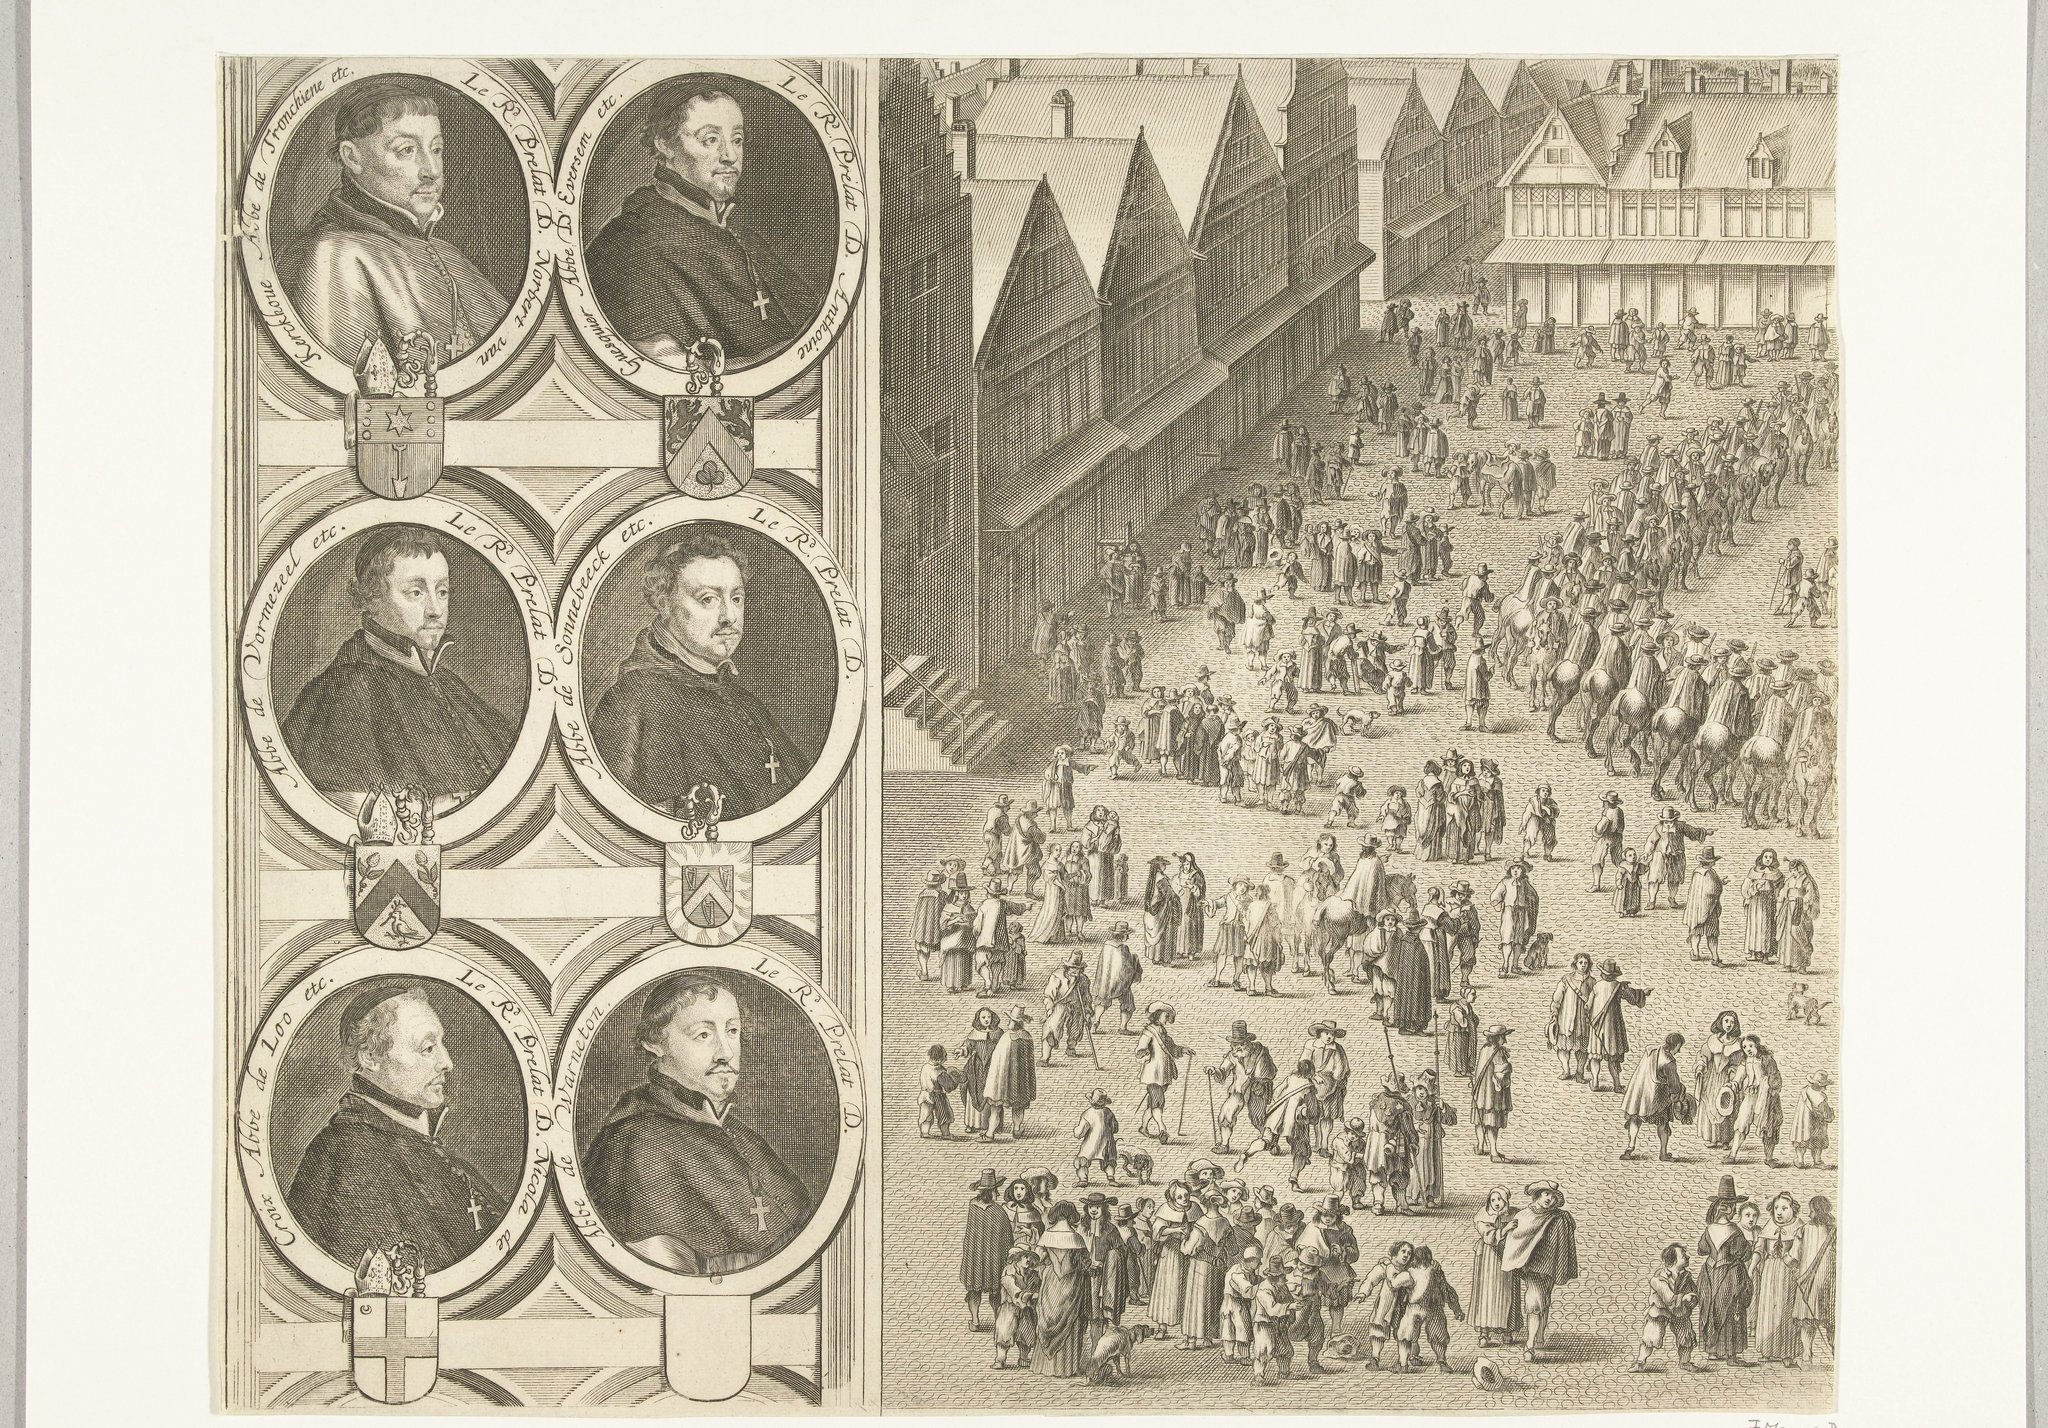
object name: print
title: Proclamatie te Gent van Karel II van Spanje als graaf van Vlaanderen (blad 4), 1666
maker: lucas vorsterman (ii)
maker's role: print maker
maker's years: 1624-1667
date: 1666-1667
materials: paper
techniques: engraving, etching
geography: southern netherlands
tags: karel ii (koning van spanje), ceremonial procession, parade, pageant ~ installation of a ruler, festivities (+ parade, pageant, cavalcade ~ festive activities)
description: Ceremonie op de Vrijdagmarkt te Gent bij de proclamatie van de Spaanse koning Karel II als graaf van Vlaanderen, 2 mei 1666. Blad 4 in een ongemonteerde ensemble van 12 platen van de ceremonie en cavalcade op het plein en 118 portretten van de hoogwaardigheidsbekleders die bij de plechtigheid aanwezig waren.